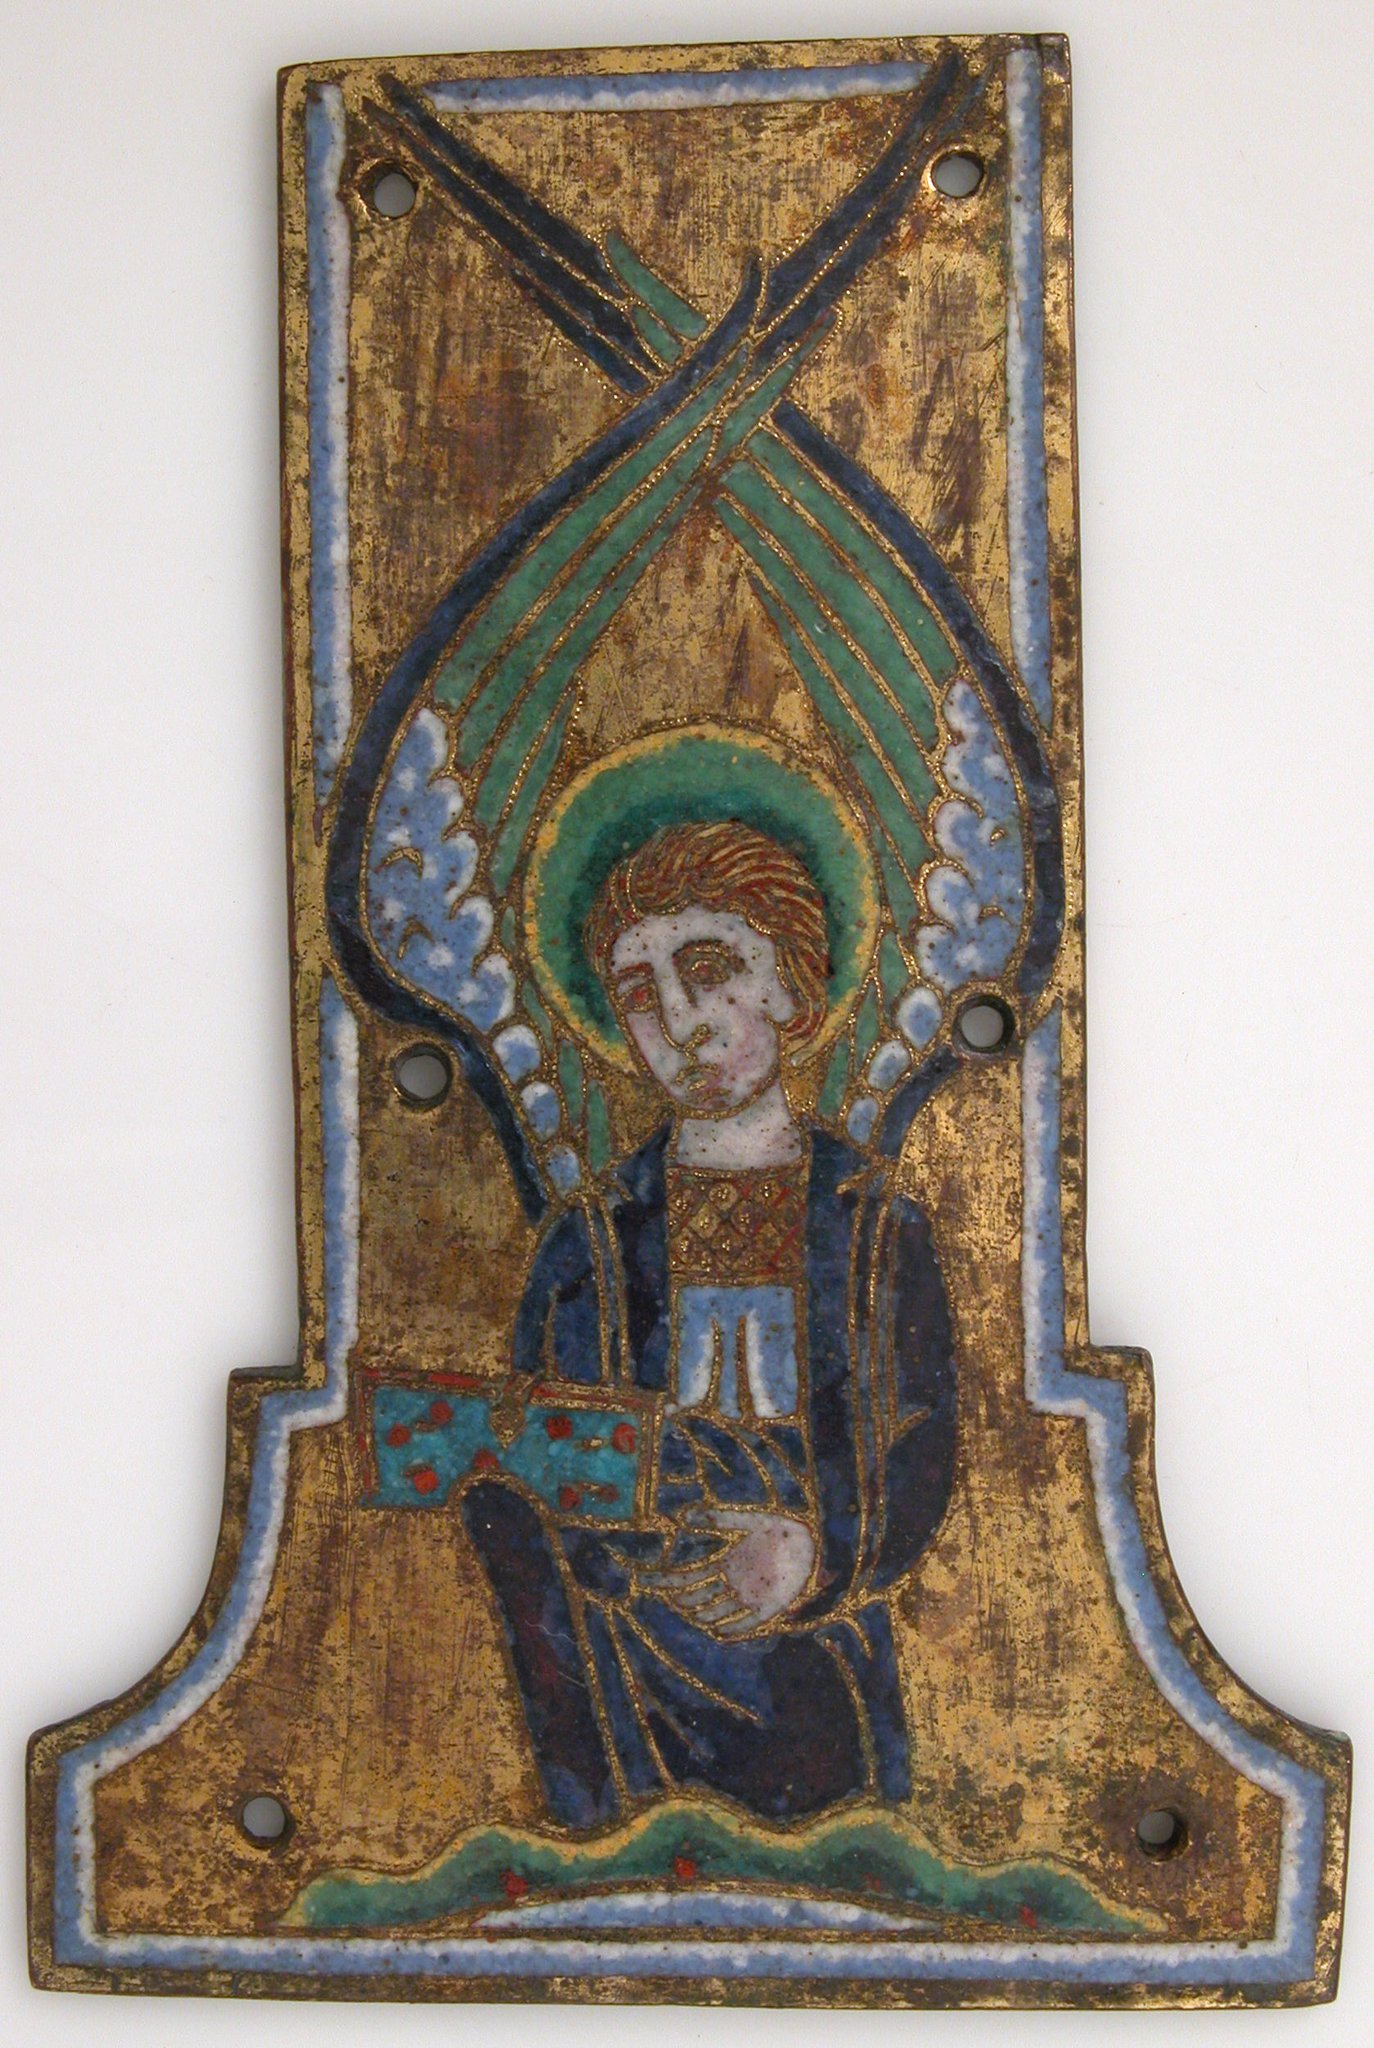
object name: plaque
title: Plaque from a Cross with the Winged Man of Saint Matthew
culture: french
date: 1185-1195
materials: copper, enamel, gilt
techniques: enamel, engraving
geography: france